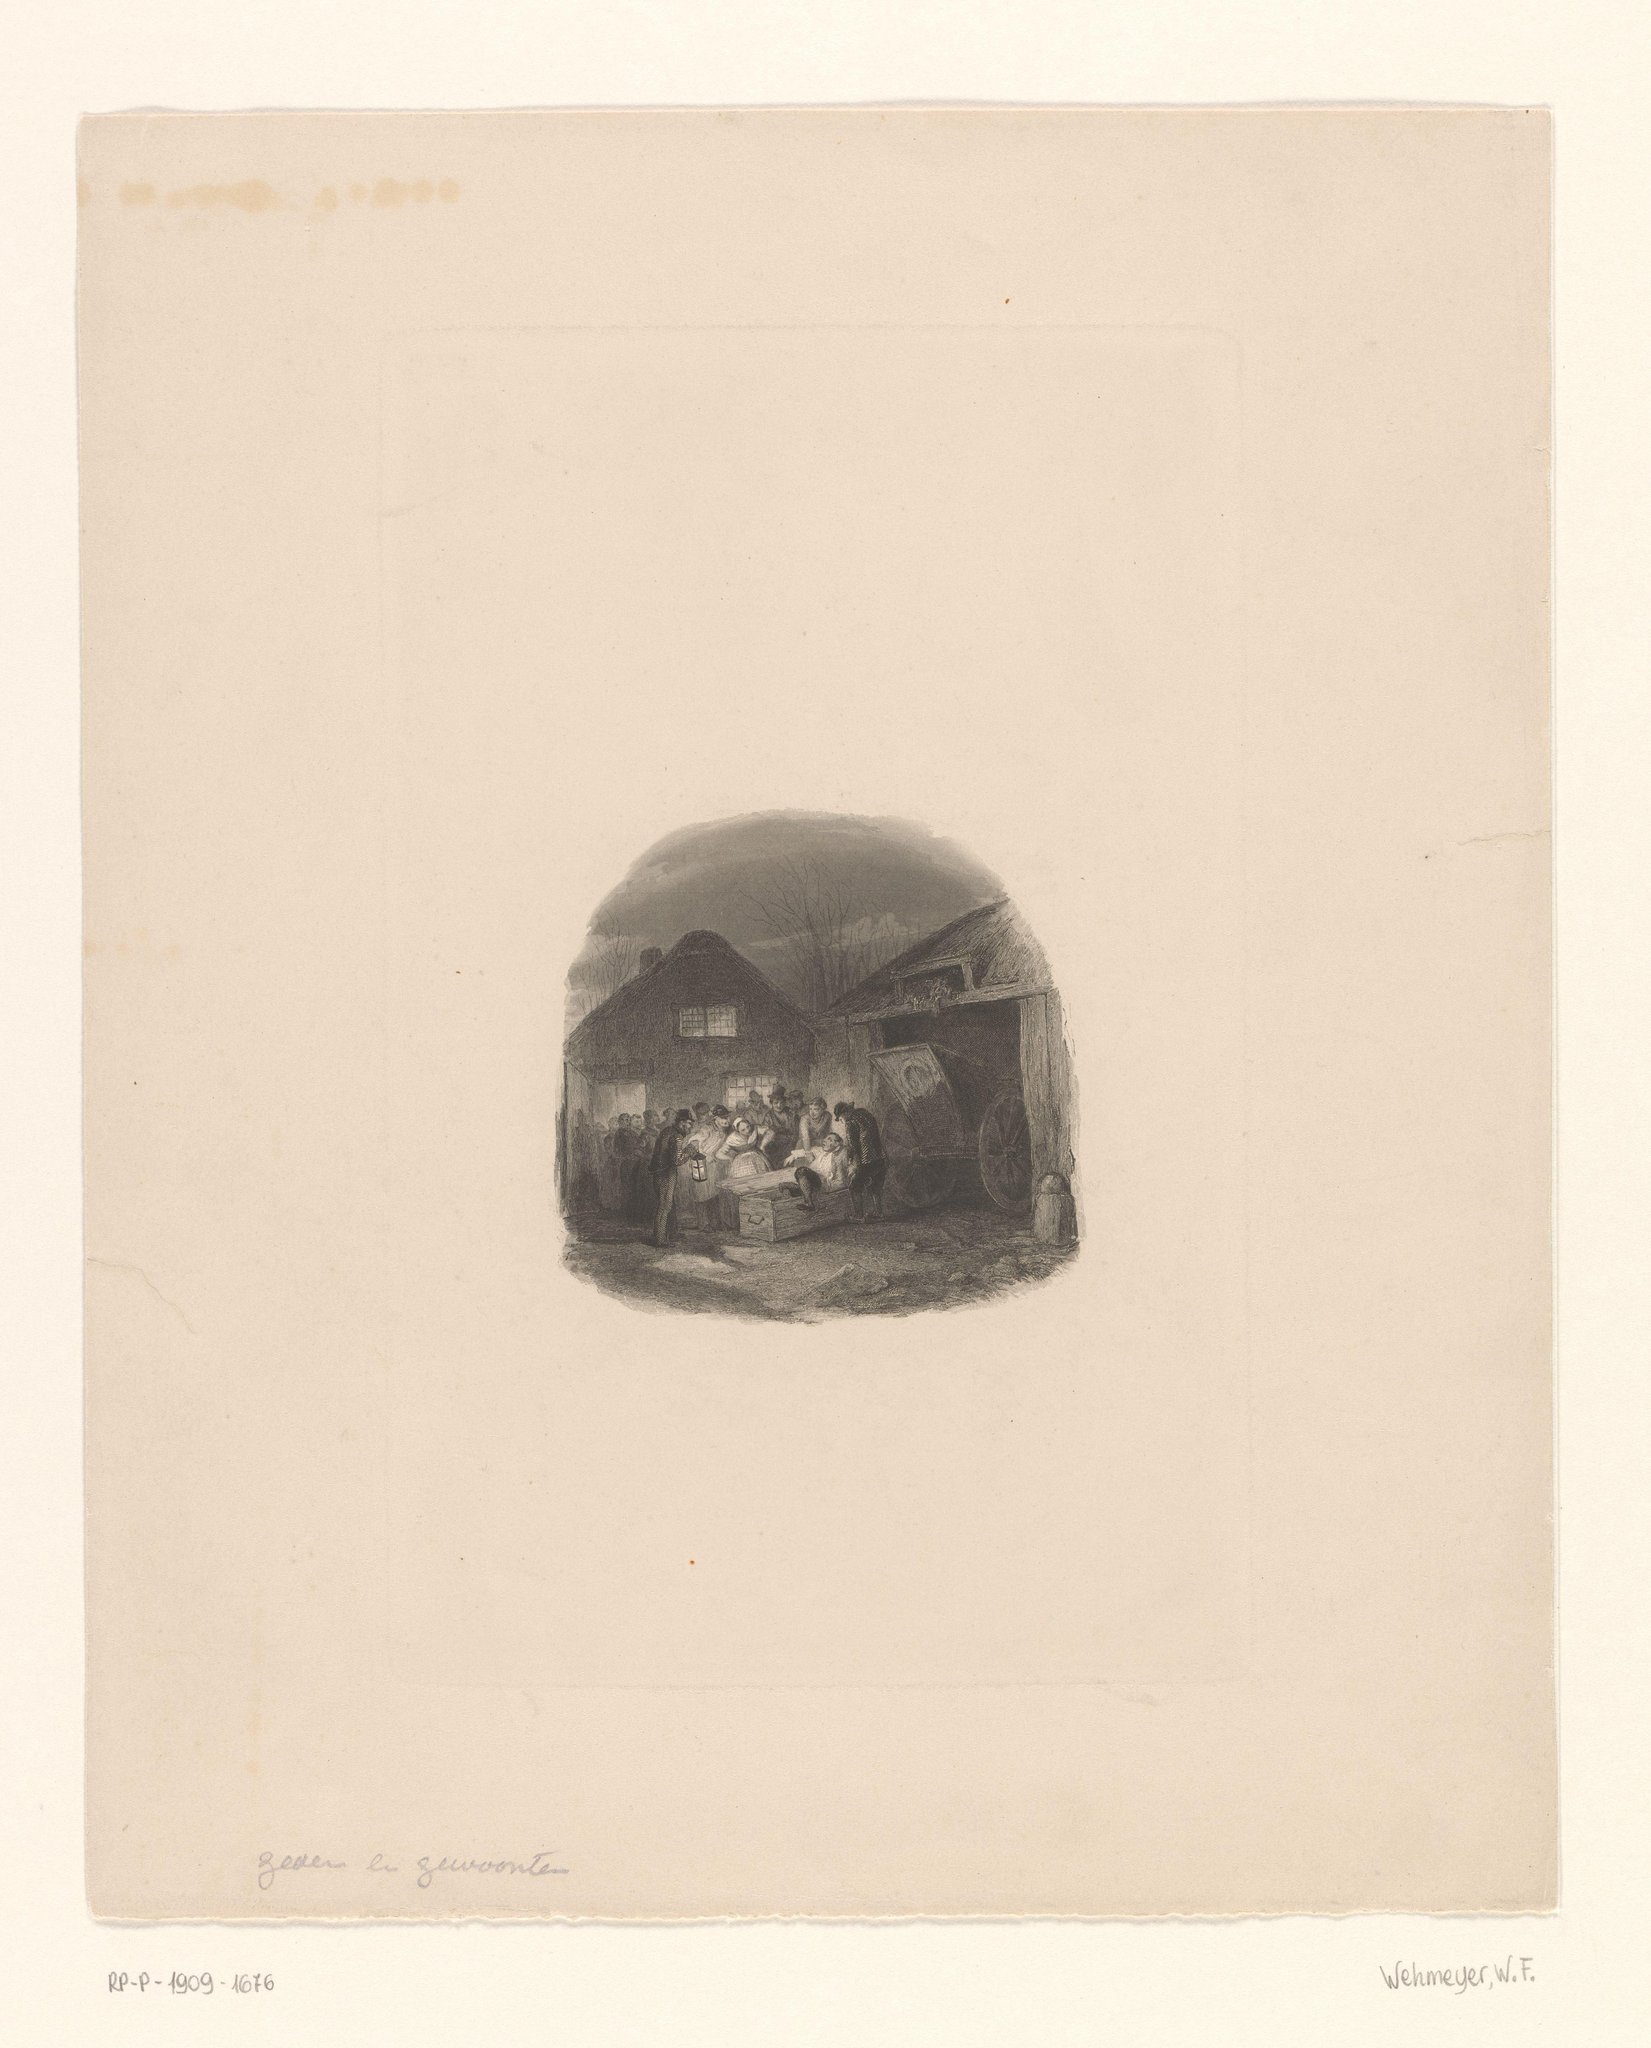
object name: print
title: Man wordt uit een kist gehaald te midden van dorpsbewoners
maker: willem frederik wehmeyer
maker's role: print maker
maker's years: 1819-1854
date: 1829-1854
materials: paper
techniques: engraving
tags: village, chest, coffer, night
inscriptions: collector's mark: Lugt 2228